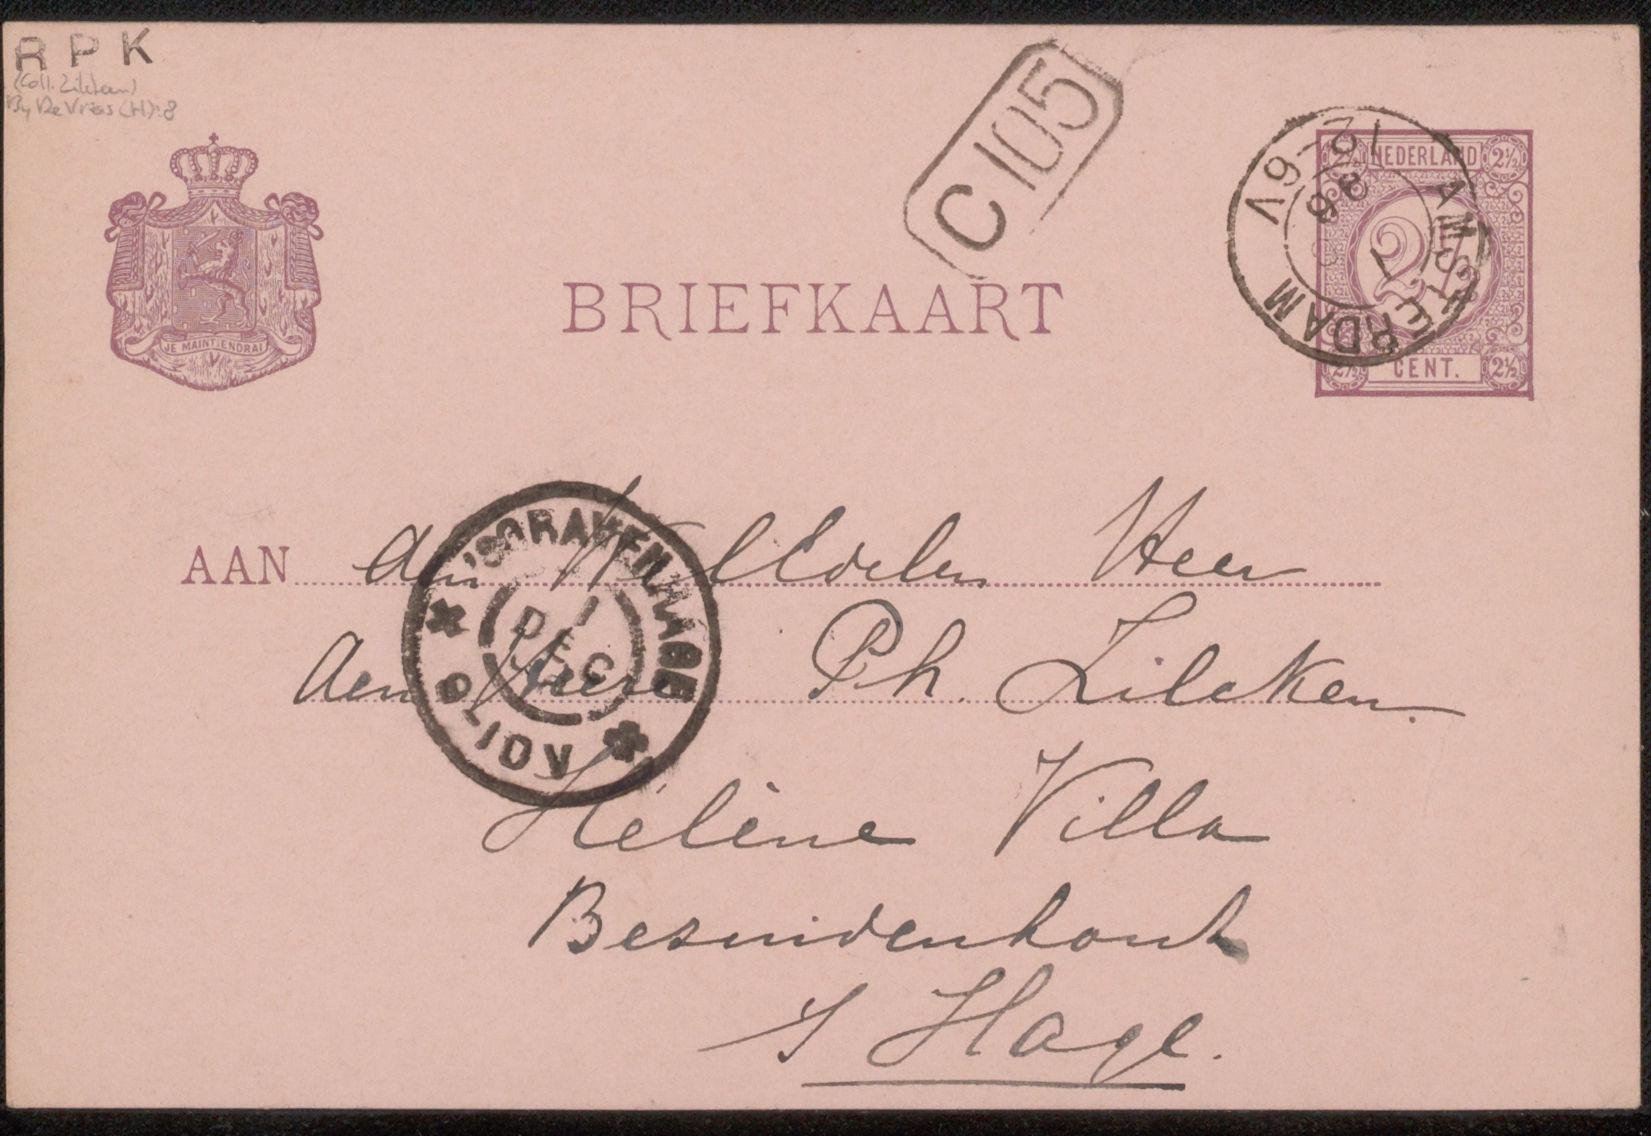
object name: postcard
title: Briefkaart aan Philip Zilcken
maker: henriëtte de vries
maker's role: draughtsman, print maker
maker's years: 1867-1942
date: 1896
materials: cardboard, ink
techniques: pen, writing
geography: amsterdam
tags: painter, draughtsman, philip zilcken, the graphic arts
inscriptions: collector's mark: ‘RPK’